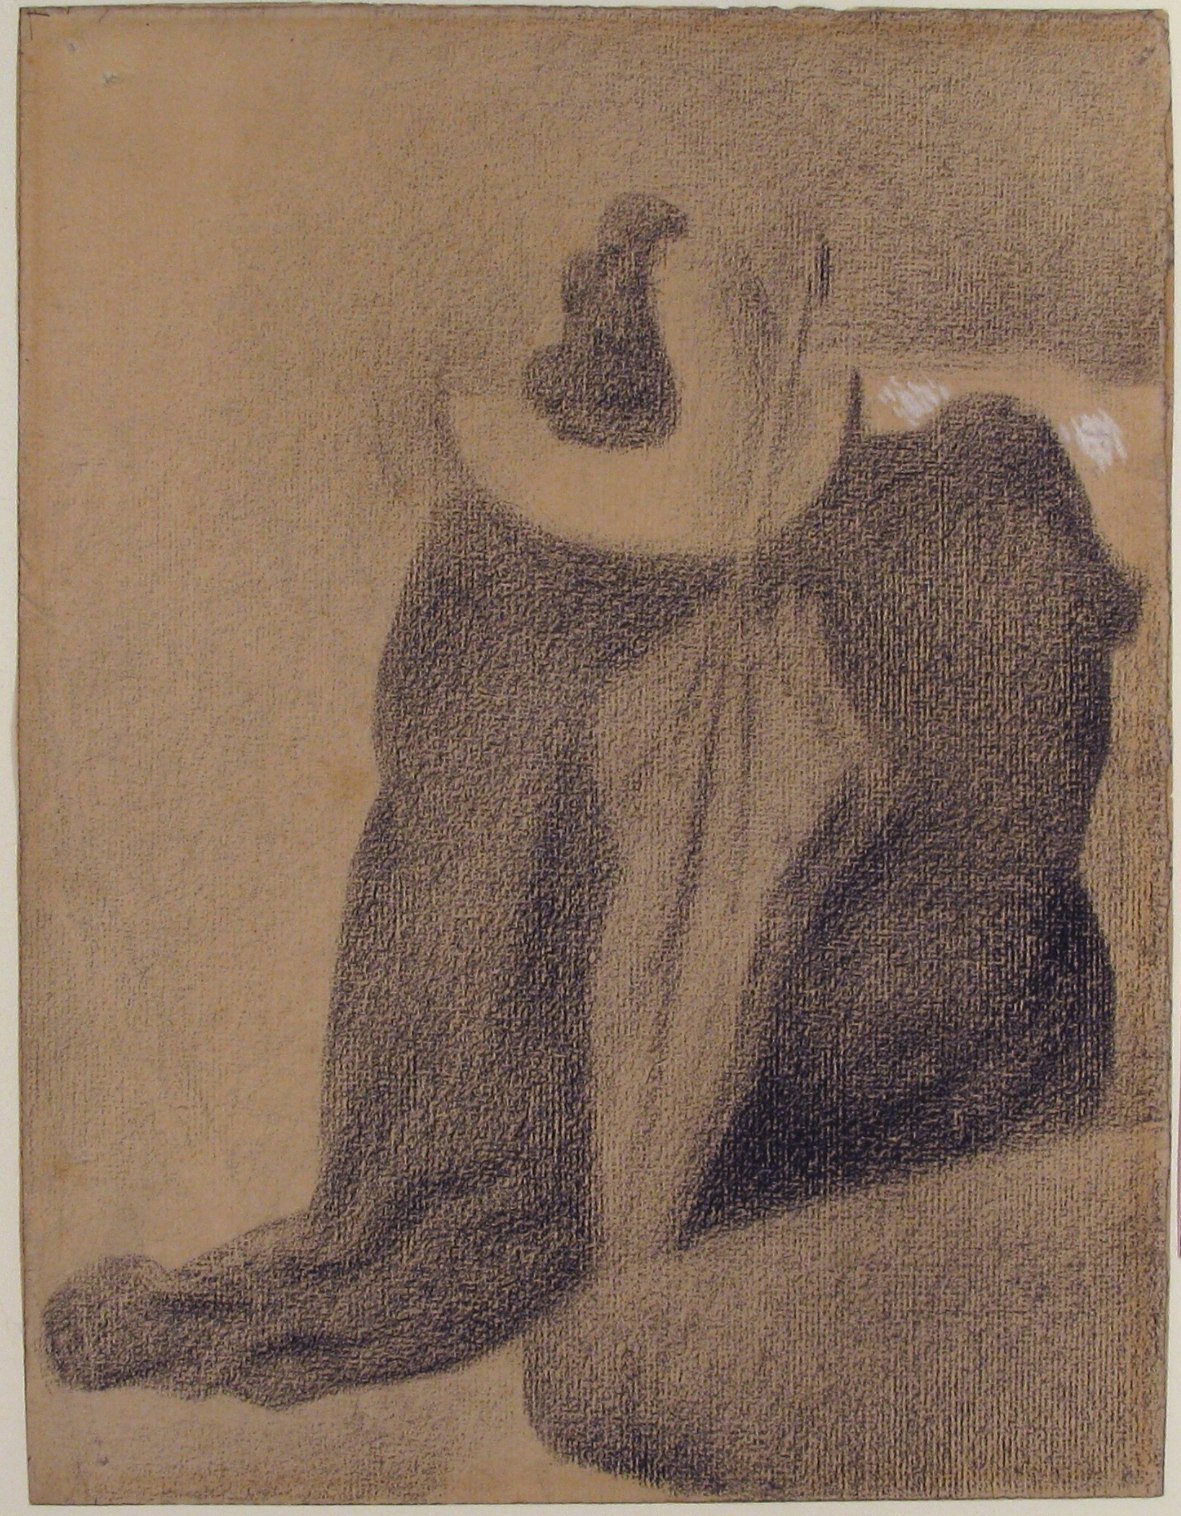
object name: drawing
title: Still Life with Hat, Parasol, and Clothes on a Chair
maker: georges seurat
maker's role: artist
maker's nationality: french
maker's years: 1859-1891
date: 1887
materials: crayon, gouache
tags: hats,still life,parasols